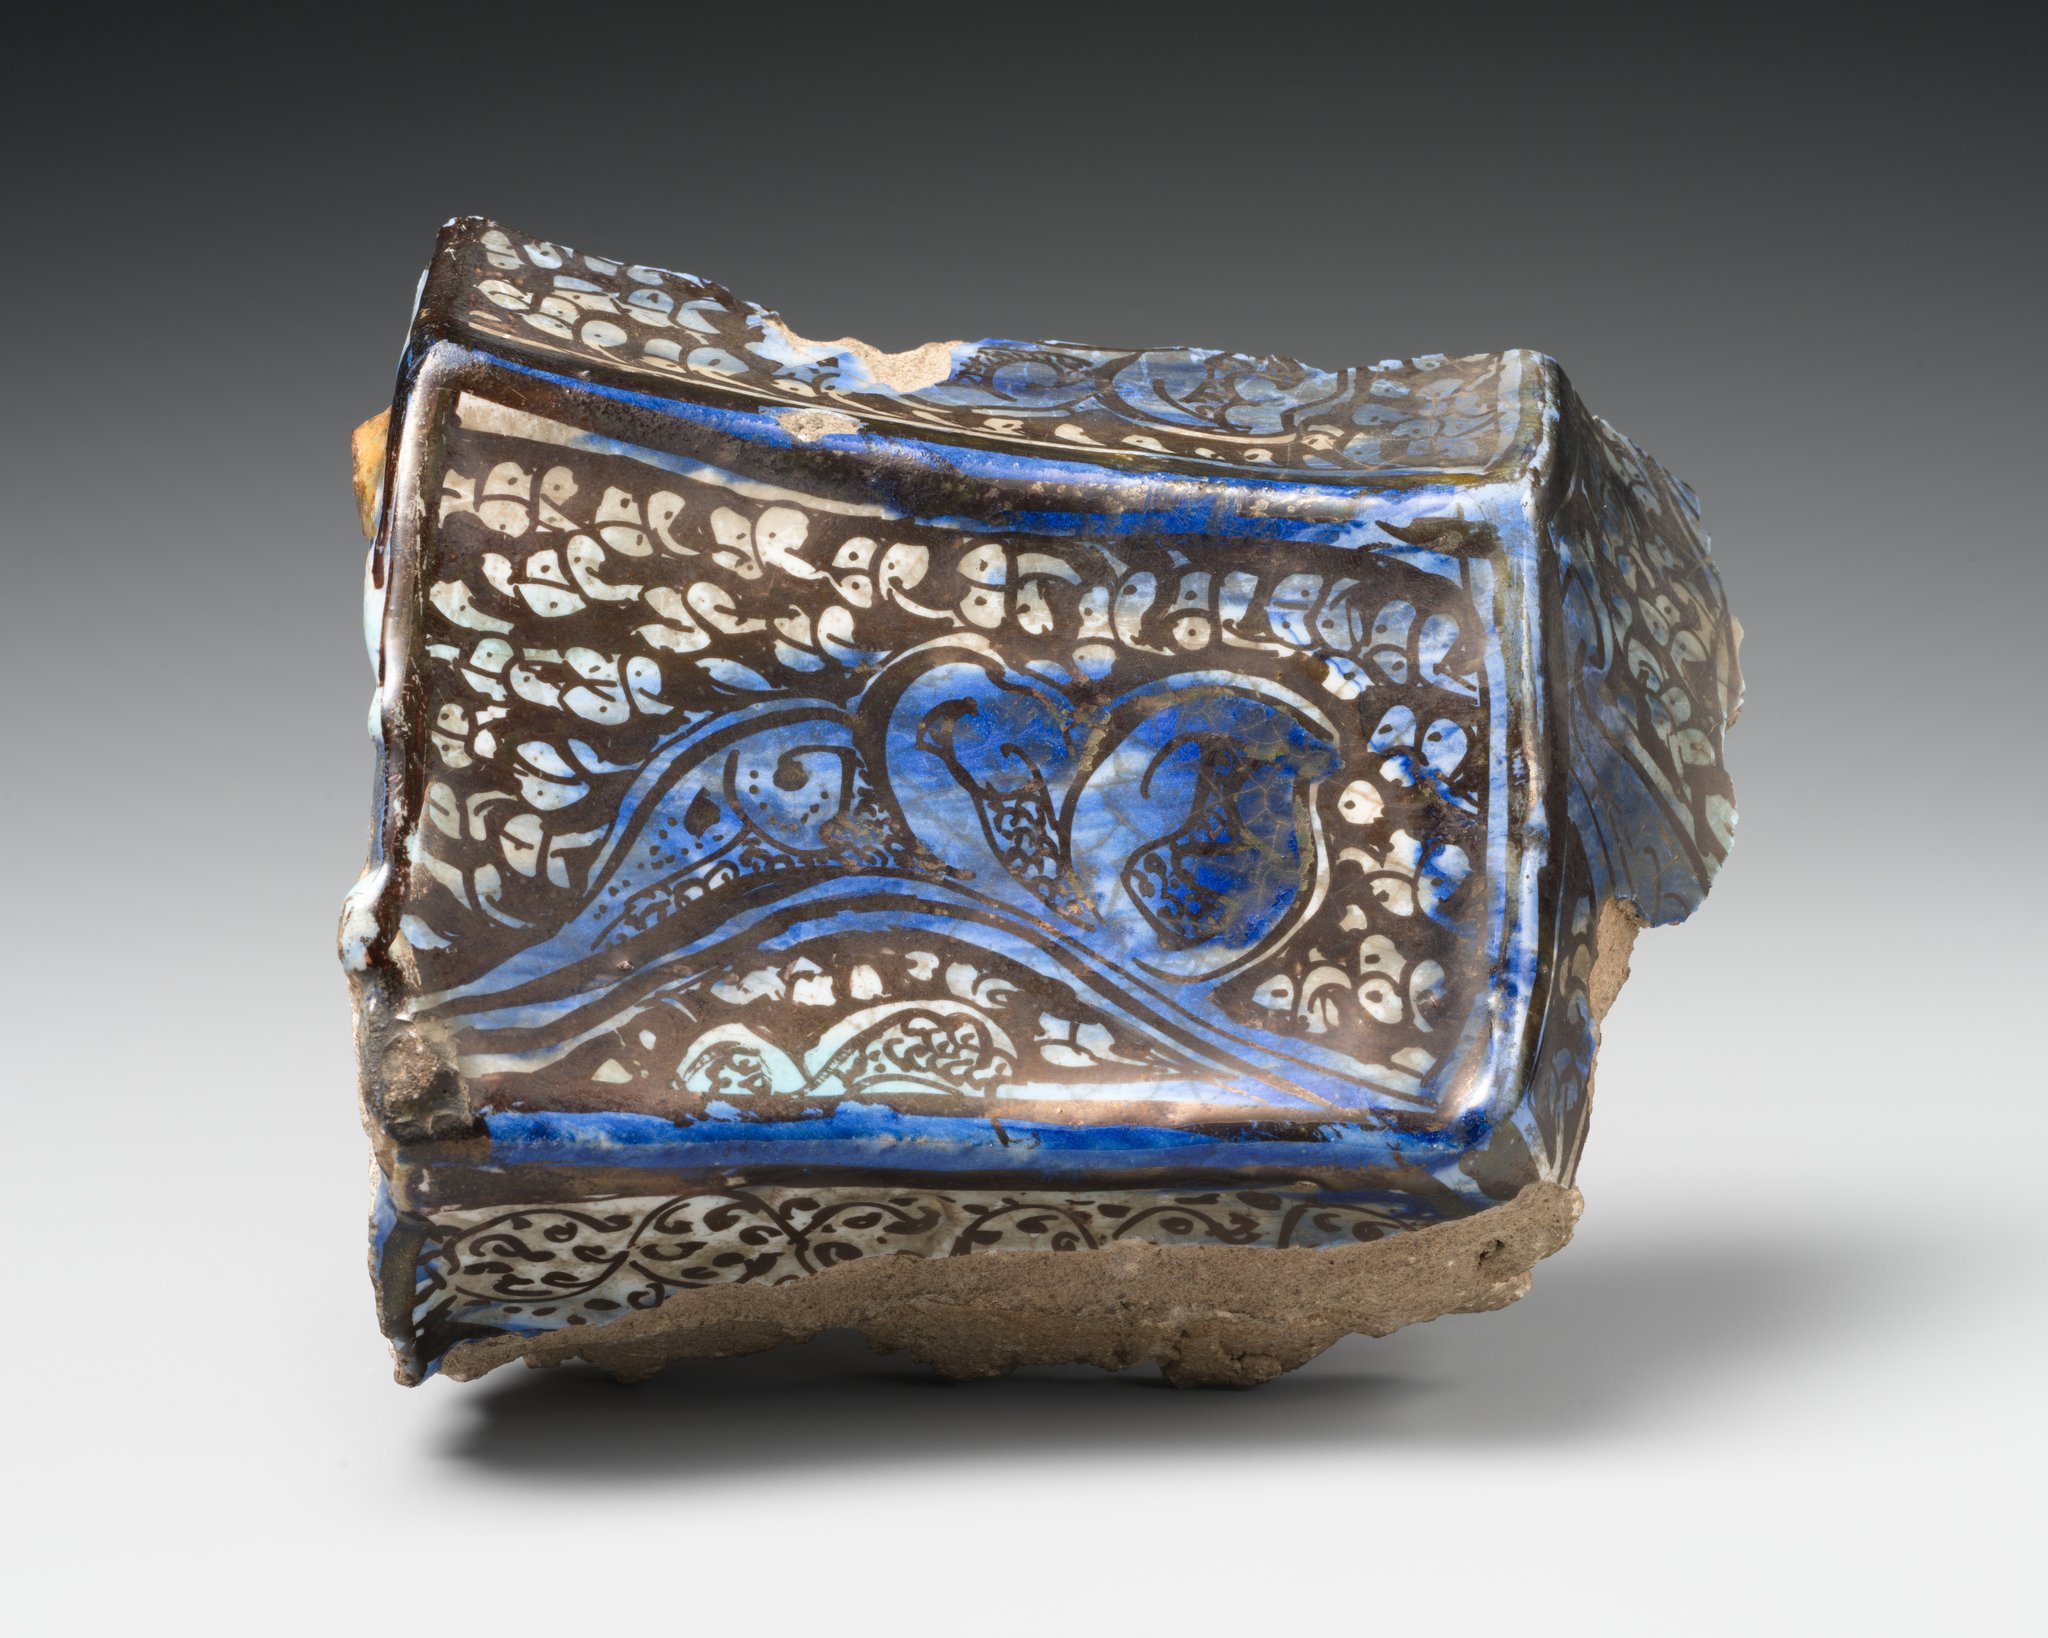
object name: tile fragment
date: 1301-1333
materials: stonepaste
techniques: luster painting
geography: iran